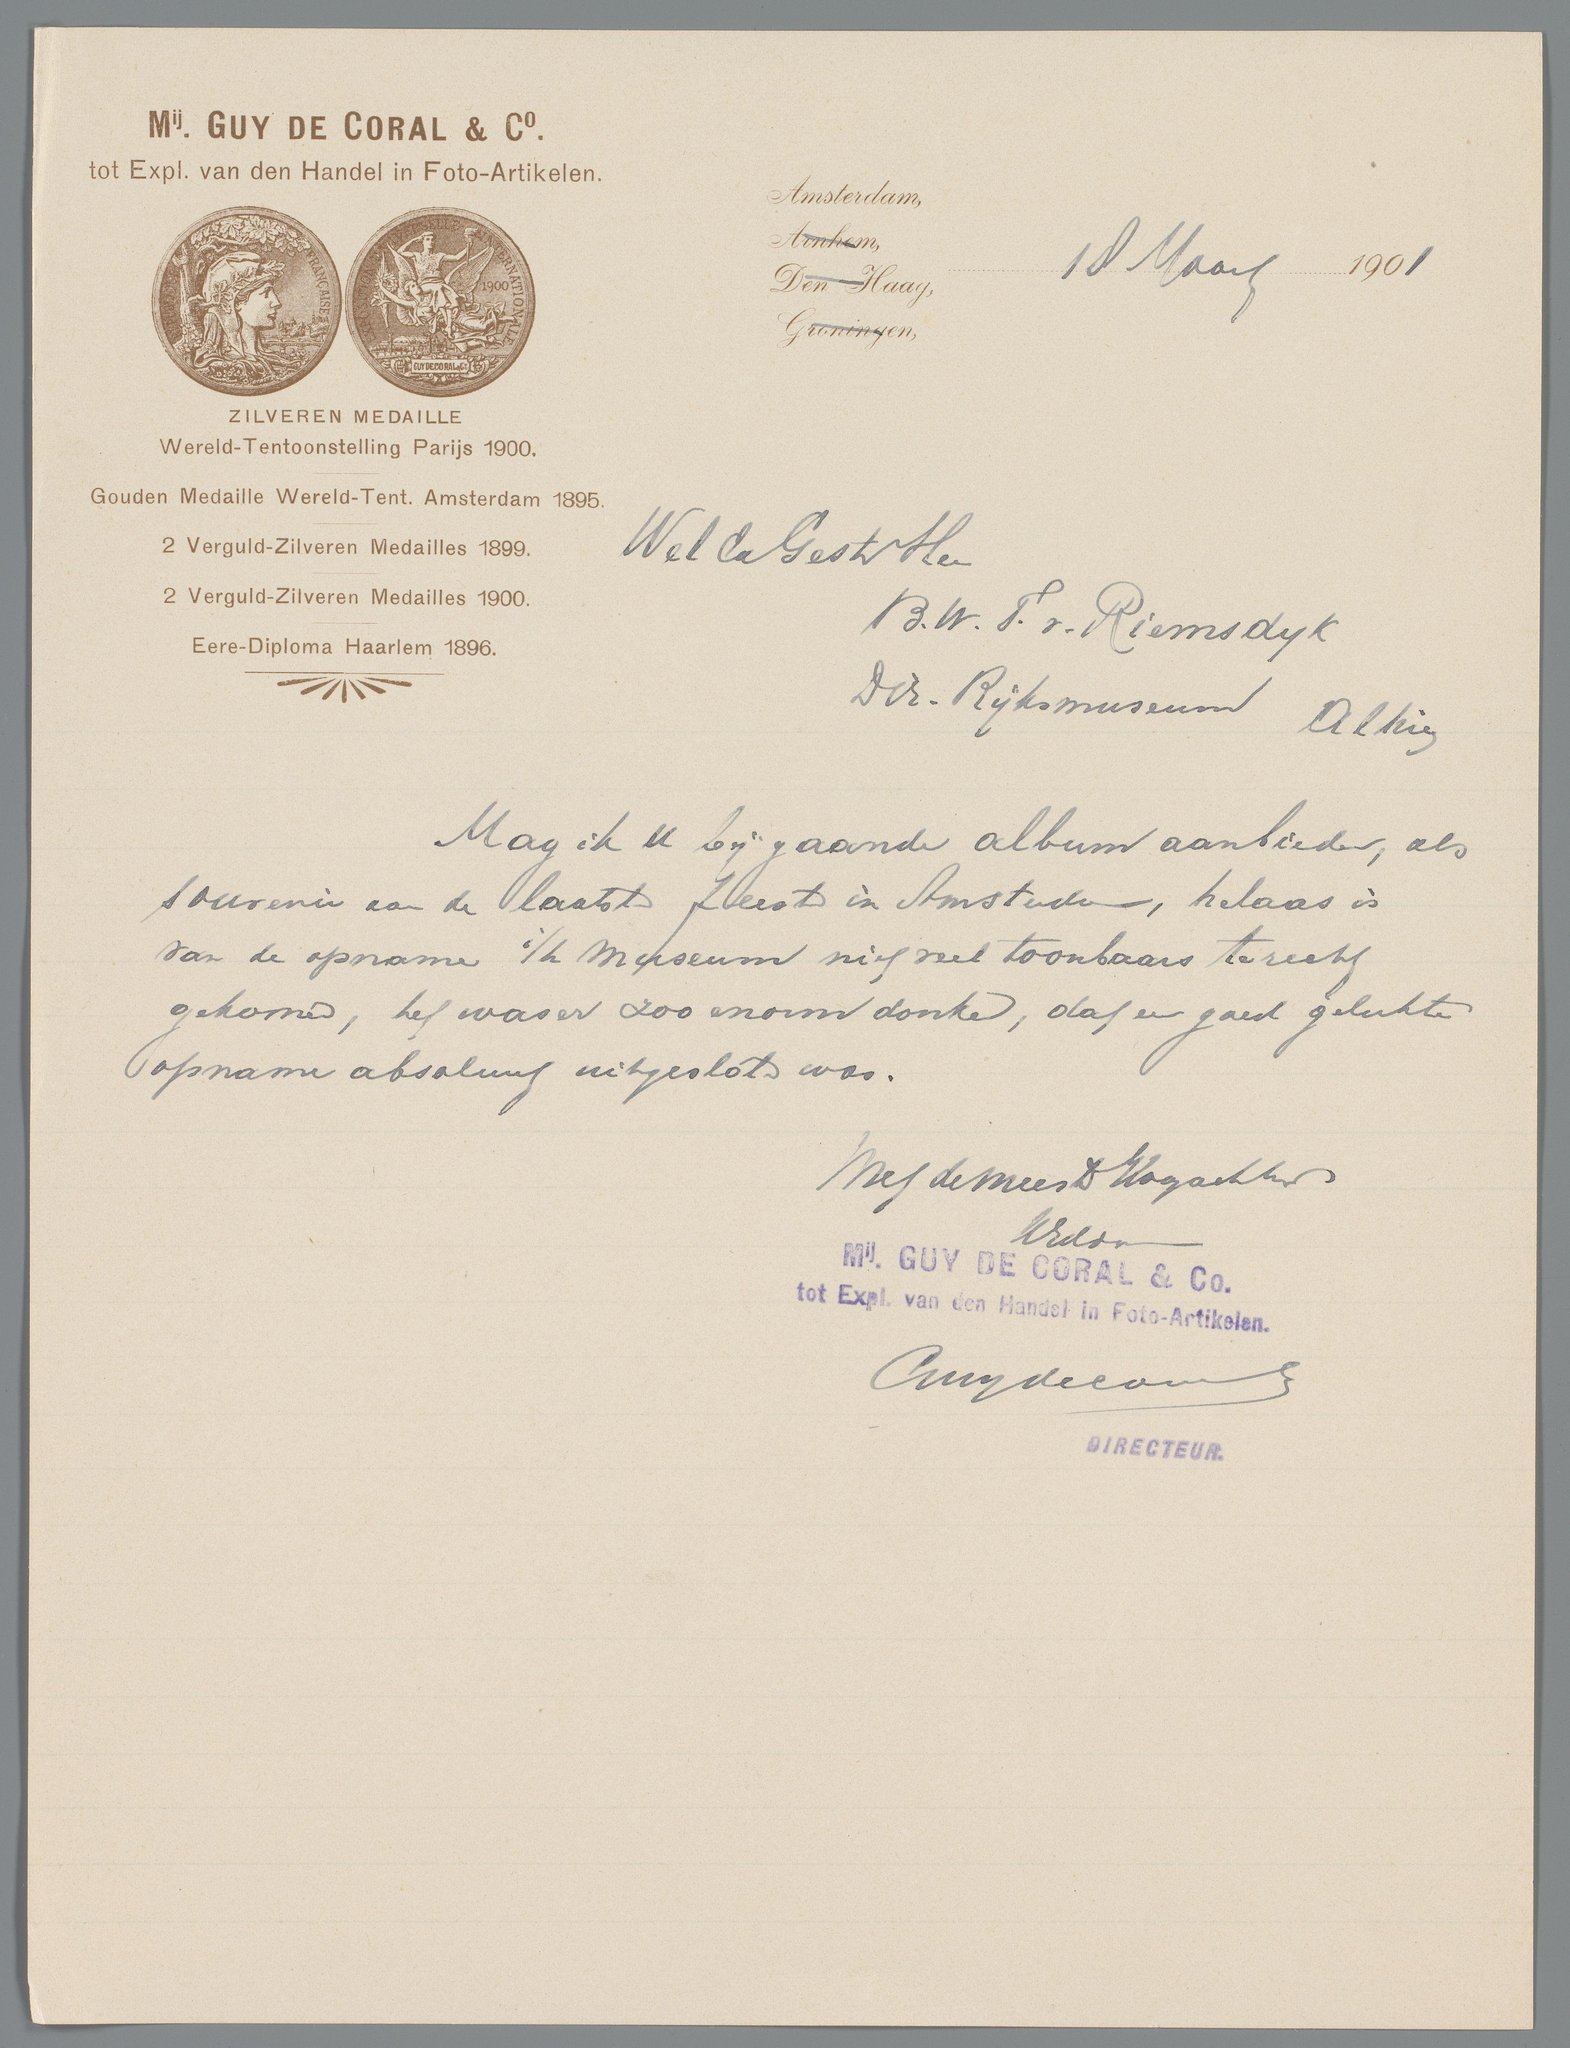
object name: letter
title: Brief gericht aan Barthold van Riemsdijk, geschreven door J.J.M. Guy de Coral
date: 1901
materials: ink, paper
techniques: pen, printing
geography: amsterdam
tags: berthold willem floris van riemsdijk, letter, envelope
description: Brief gericht aan Barthold van Riemsdijk, geschreven door J.J.M. Guy de Coral waarin hij een album aan de ontvanger van de brief aanbiedt als souvenier aan een feest te Amsterdam. Tevens wordt veronschuldigd dat de opname die in het museum genomen is wegens gebrek aan licht niet is gelukt.